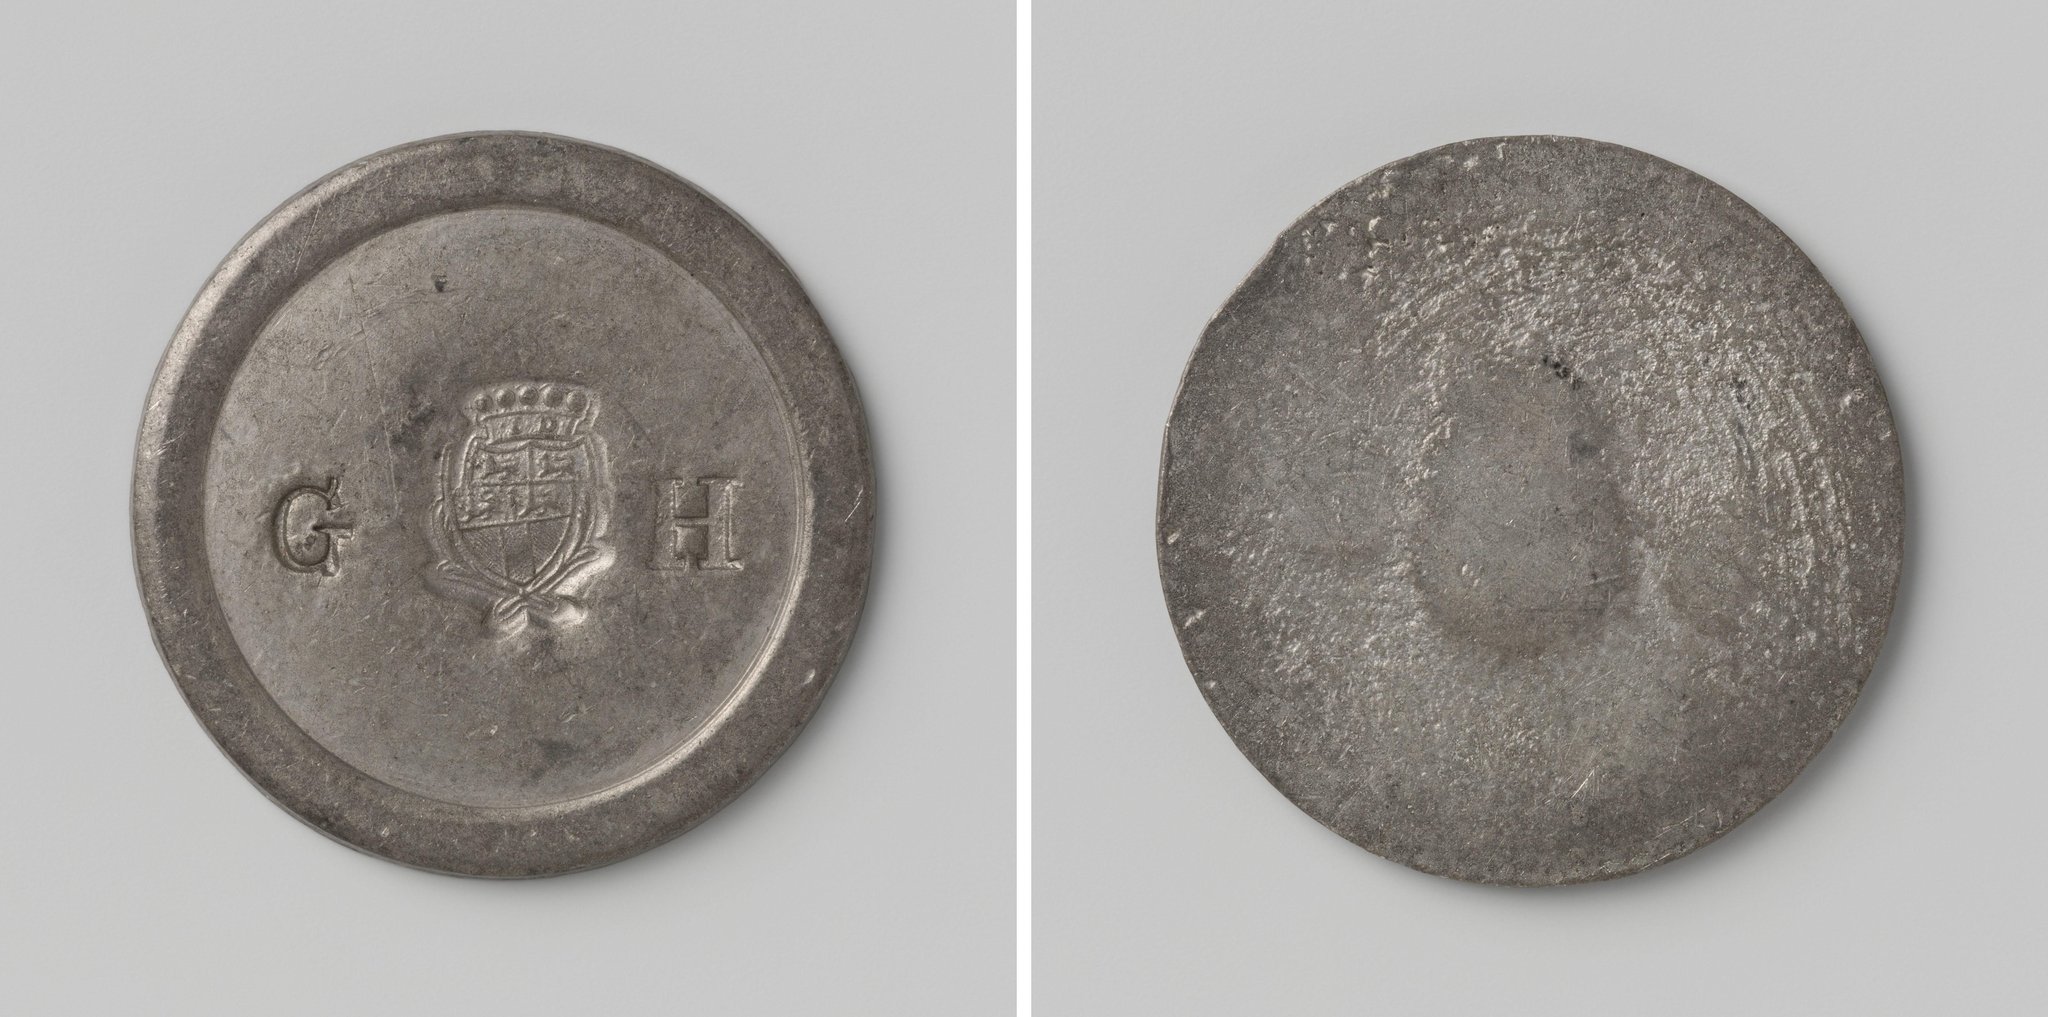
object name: toegangspenning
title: Gasthuis te Rotterdam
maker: Anonymous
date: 1600-1800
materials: lead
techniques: striking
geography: rotterdam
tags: rotterdam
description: Eenzijdige loden penning. Voorzijde: twee stempels: gekroond wapenschild op twee bladertakken, tussen letters G en H. Keerzijde: blanco